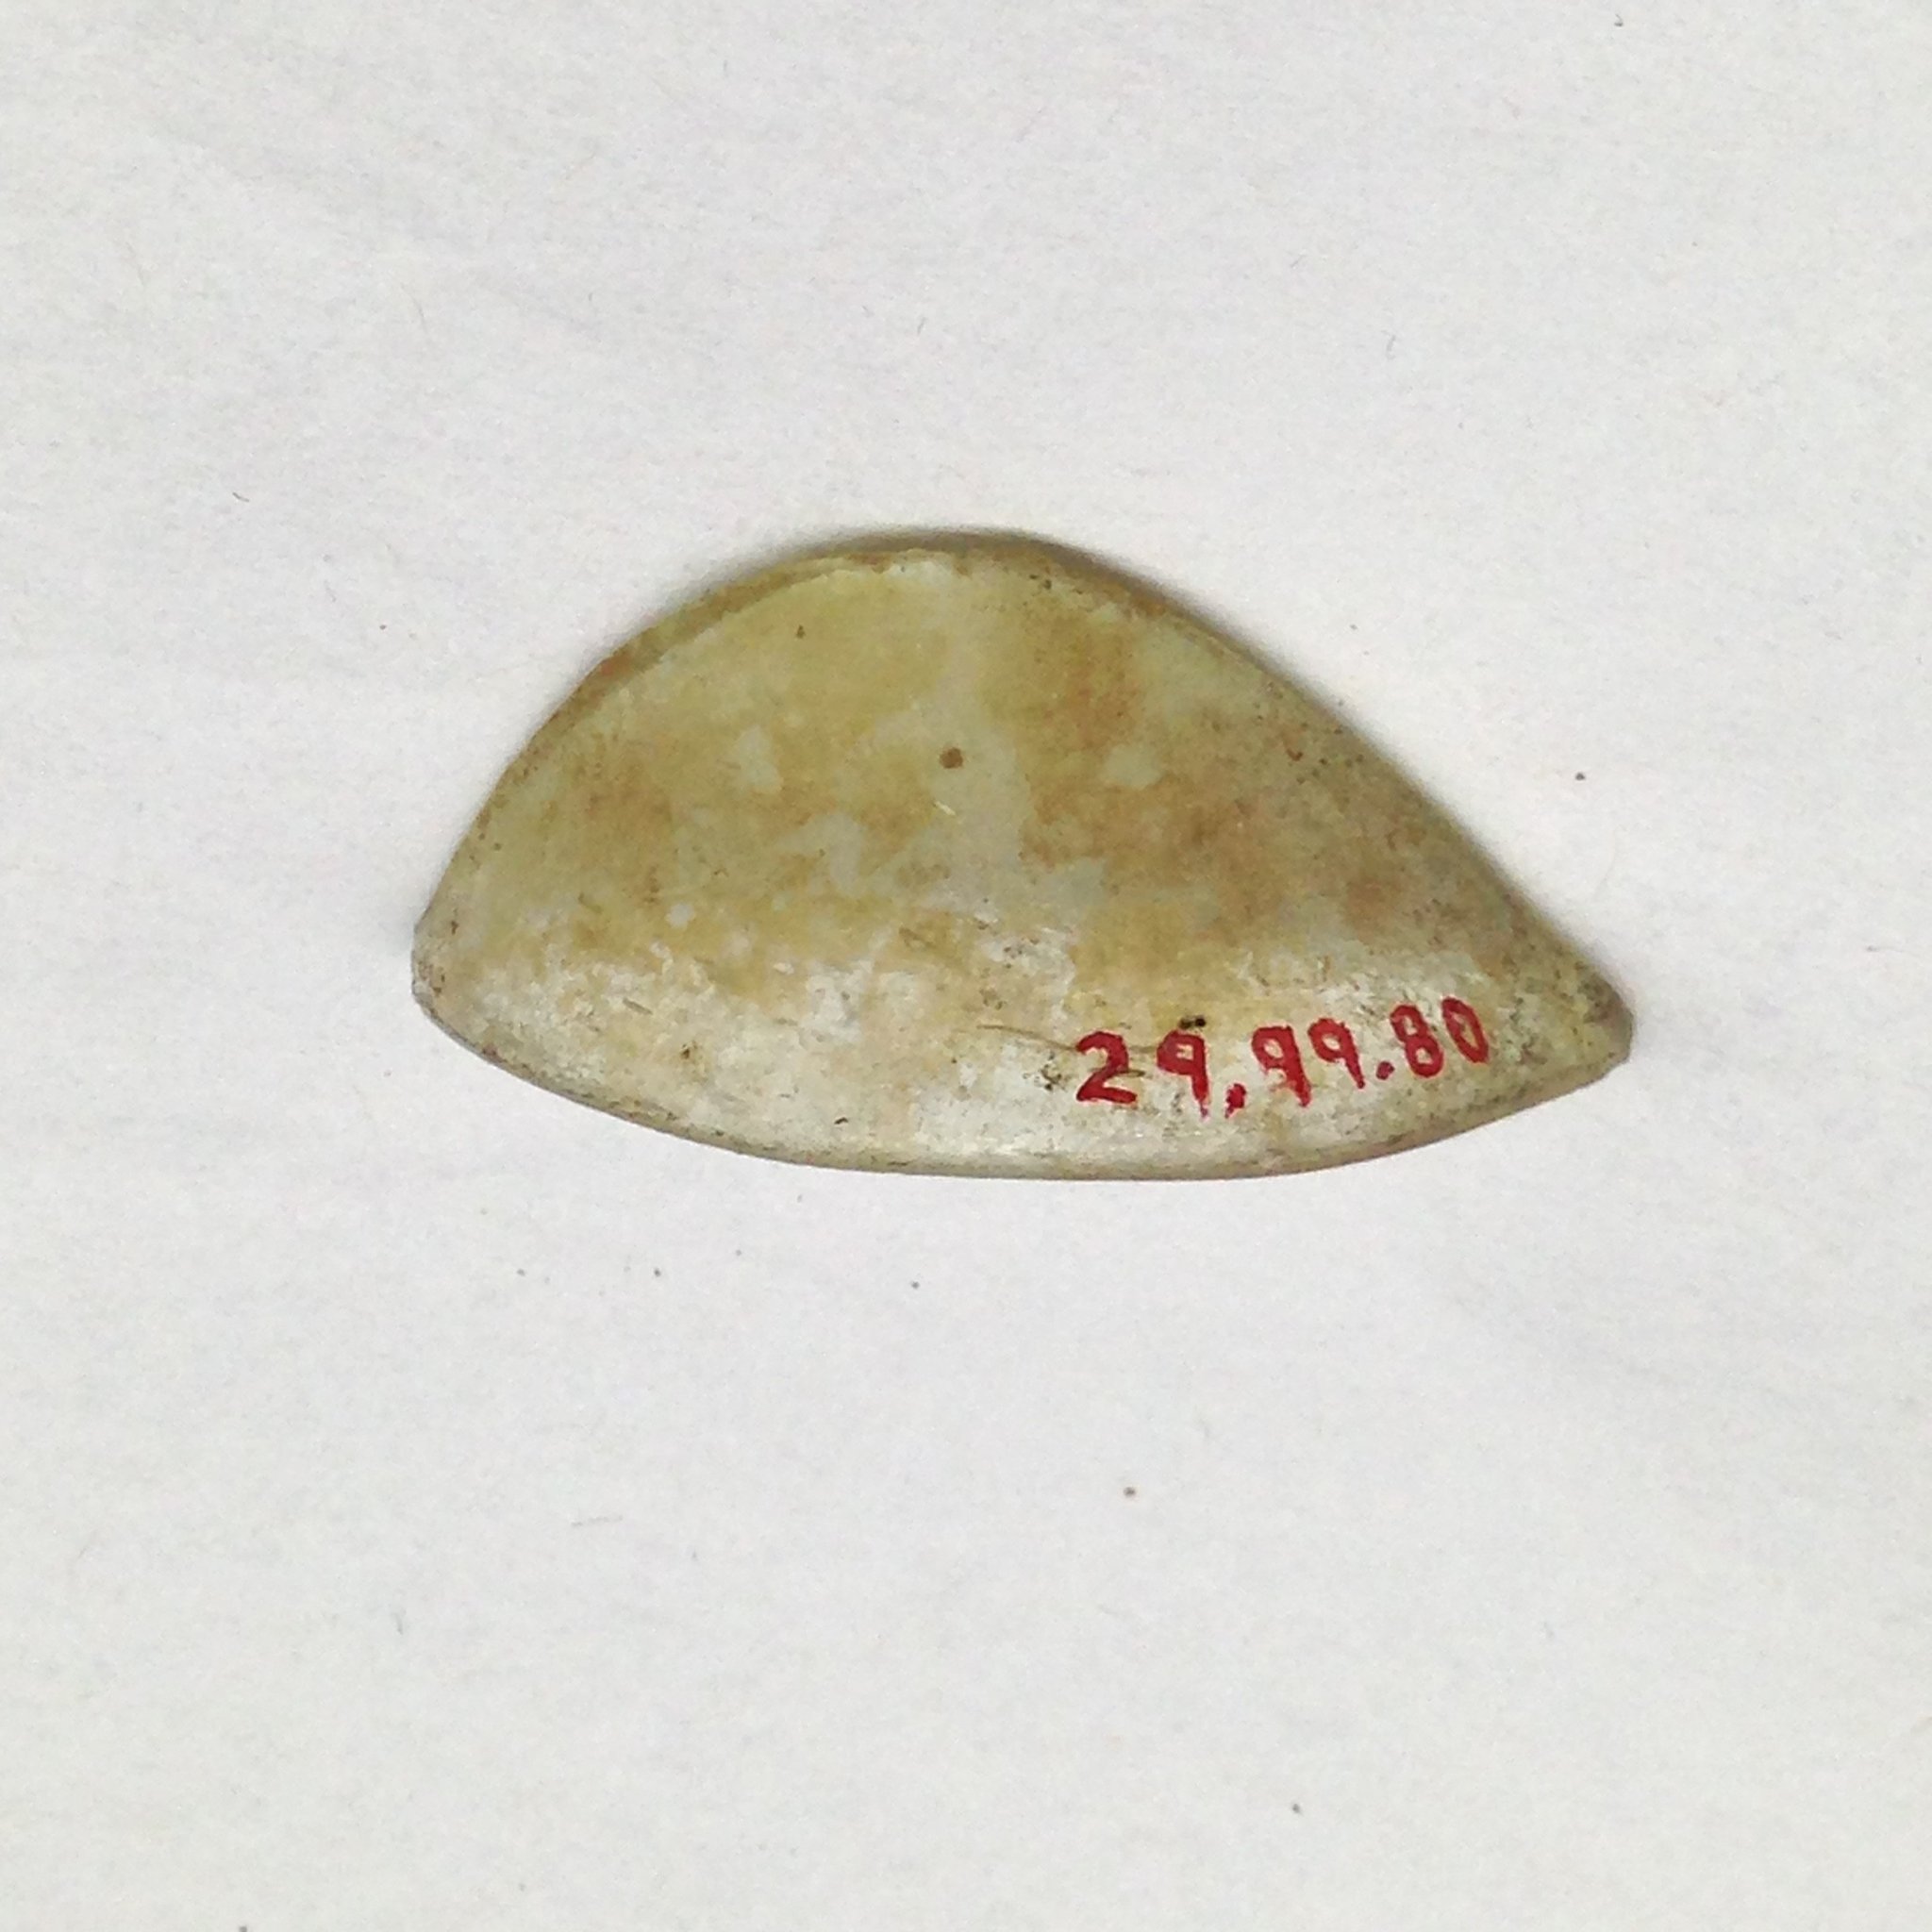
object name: fragment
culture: european or middle eastern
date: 1150-1250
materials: ceramic, glass